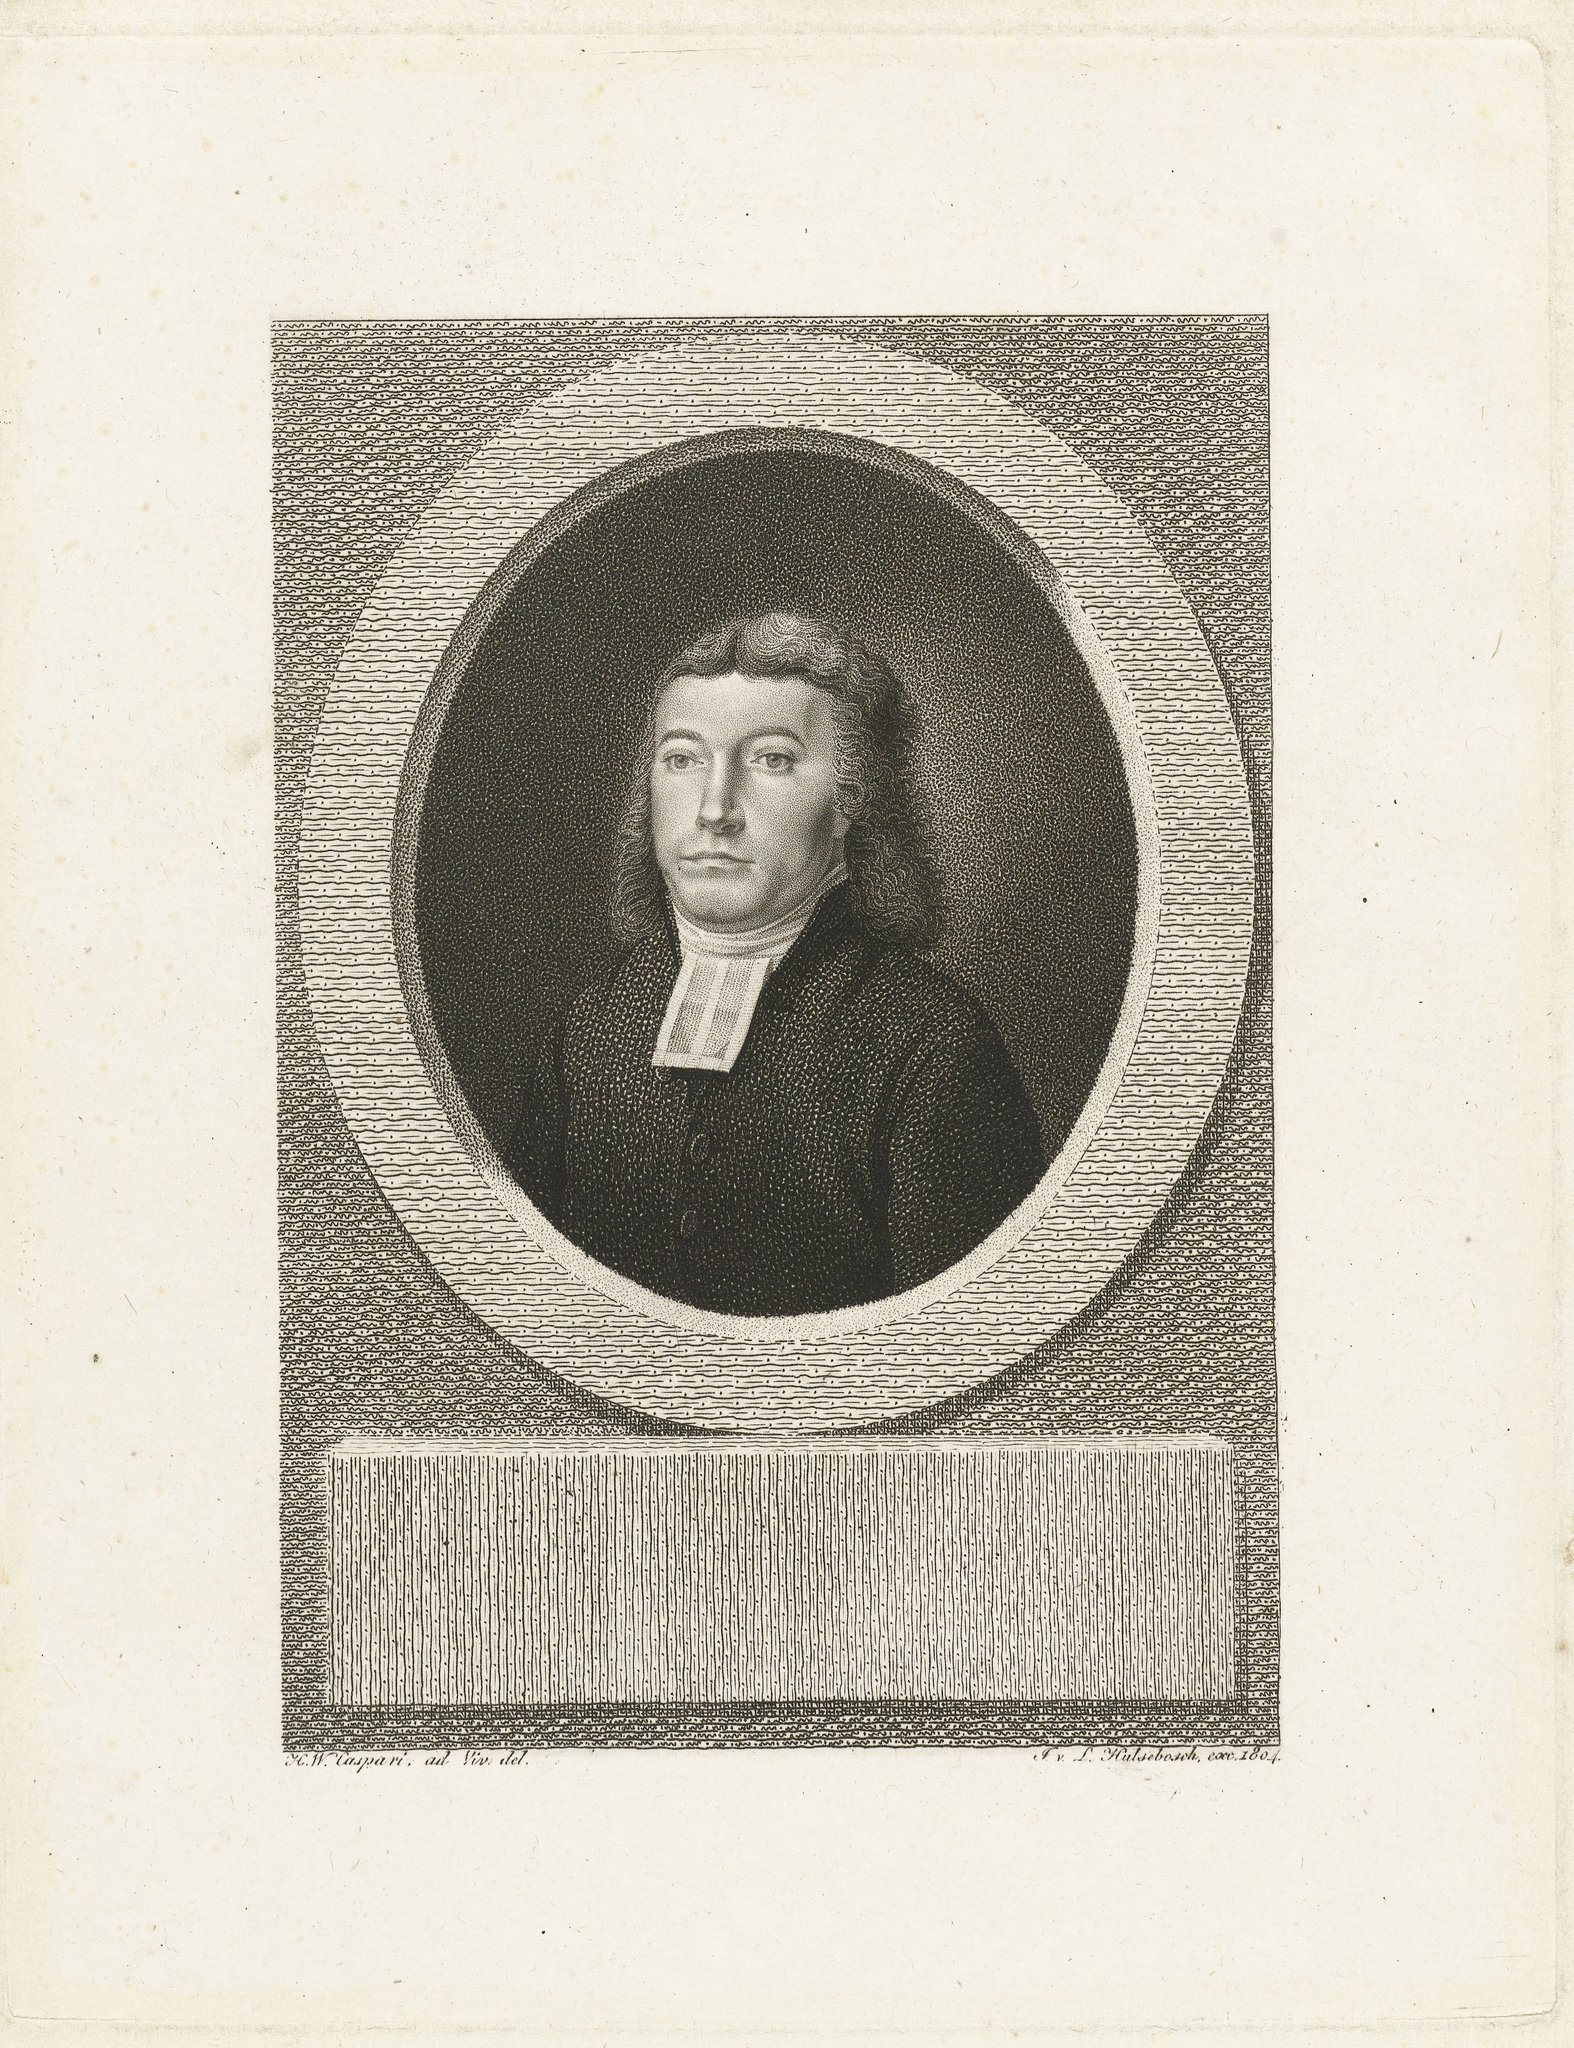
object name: print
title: Portret van Henricus Oort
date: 1804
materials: paper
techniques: etching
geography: amsterdam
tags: predikant, henricus oort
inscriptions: collector's mark: Lugt 2166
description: Portret in ovale lijst van Henricus Oort, predikant te Zwolle en Hoogeveen. Buste naar links. Oort heeft een zwarte toga aan met een witte bef.